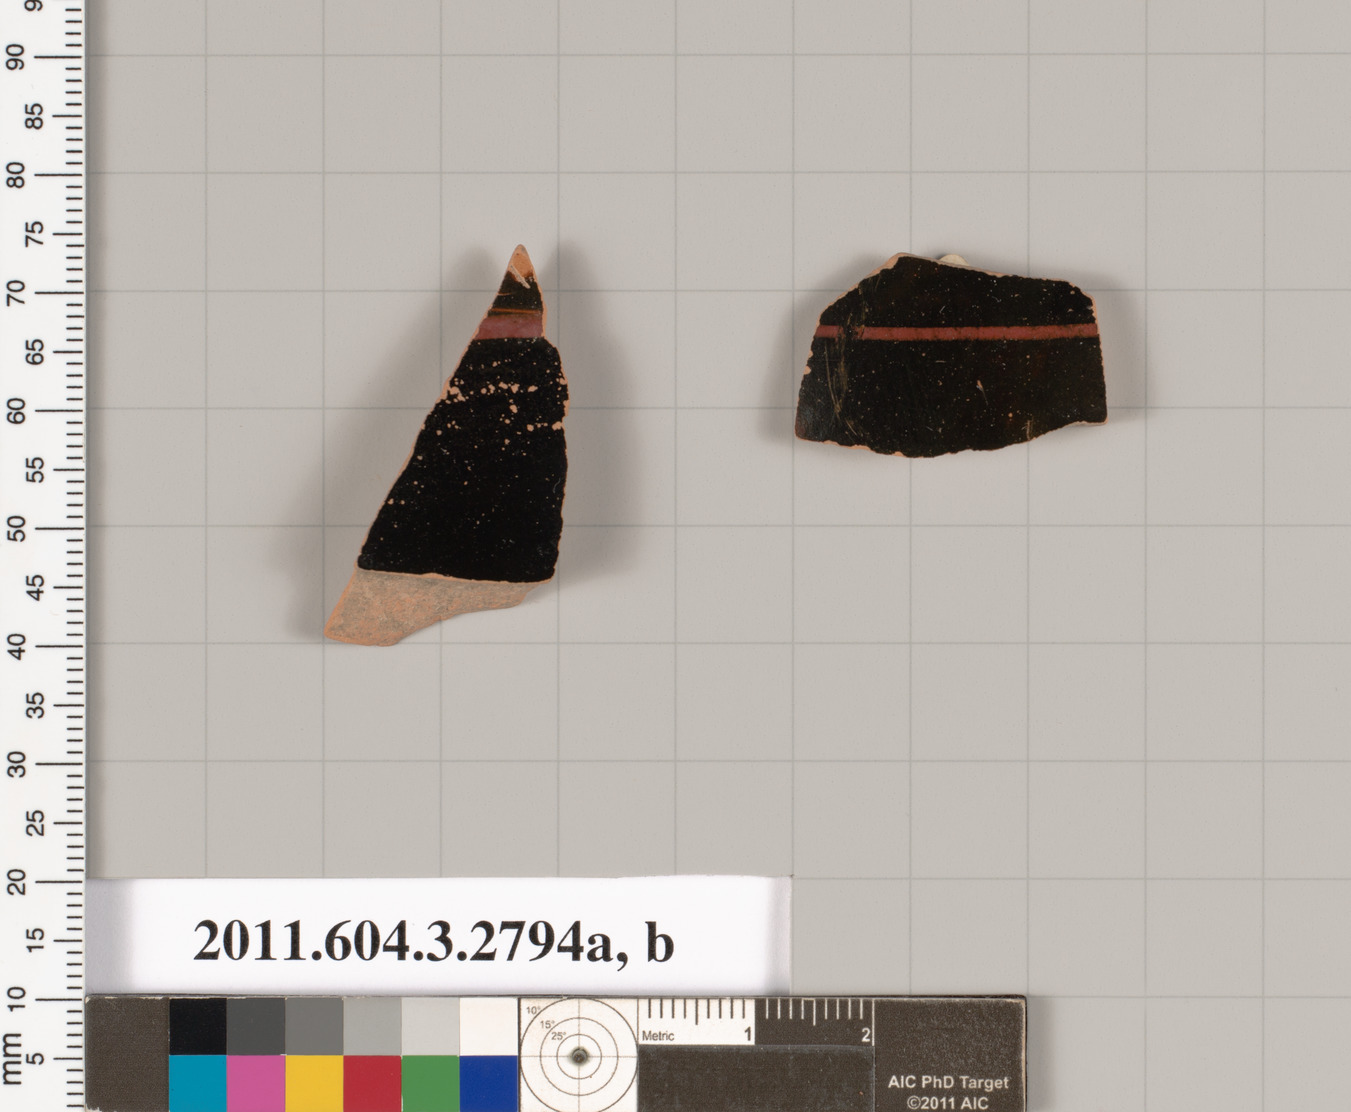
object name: oinochoe or olpe fragment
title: Terracotta fragments of oinochoai (jugs) or olpai (jugs)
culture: greek, attic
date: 600-401 BCE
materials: terracotta